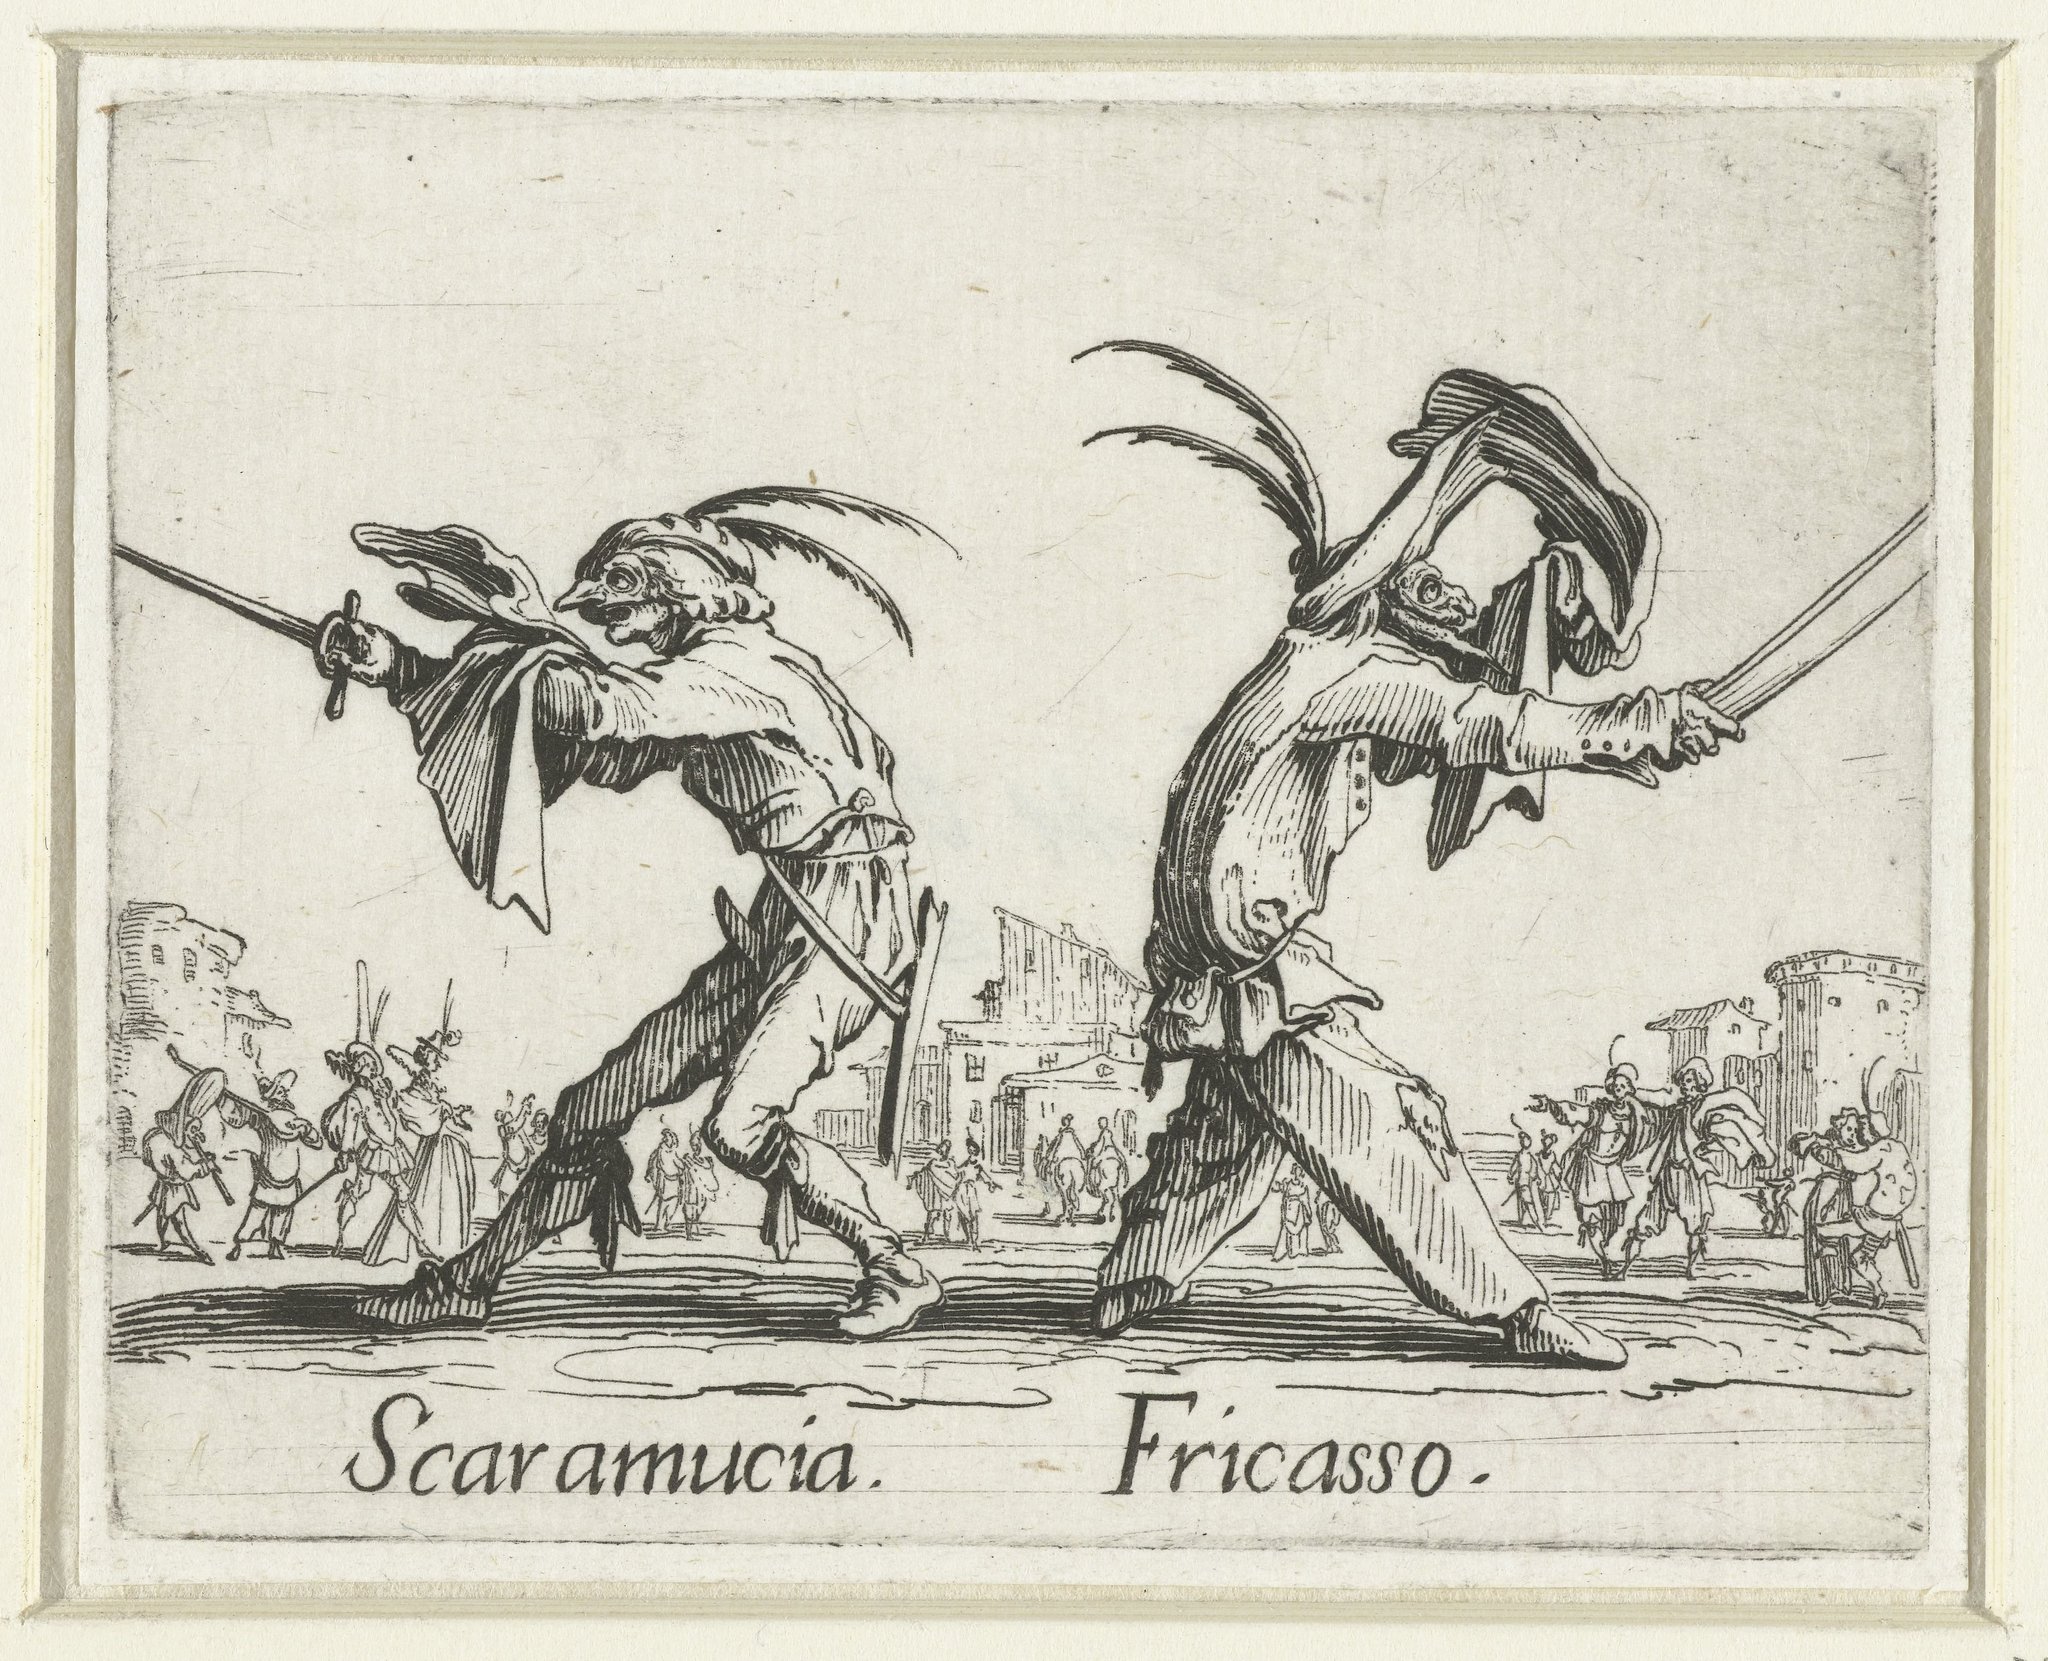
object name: print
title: Dansen van Sfessania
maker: jacques callot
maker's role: draughtsman, print maker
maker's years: 1592-1635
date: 1621-1622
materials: paper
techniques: etching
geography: nancy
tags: types in 'commedia dell'arte'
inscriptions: collector's mark: Lugt 240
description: Twee artiesten met gevederde hoofddeksels op en met getrokken zwaarden in de hand staan met de rug naar elkaar toe. Onder de figuren staan hun namen genoteerd. Deze prent is onderdeel van een serie van 23 prenten (24 incl. titelprent) met telkens op de voorgrond twee straatartiesten verkleed als figuren uit de Italiaanse commedia dell'arte, en op de achtergrond toeschouwers die in de buitenlucht een (dans)voorstelling van straatartiesten gadeslaan.